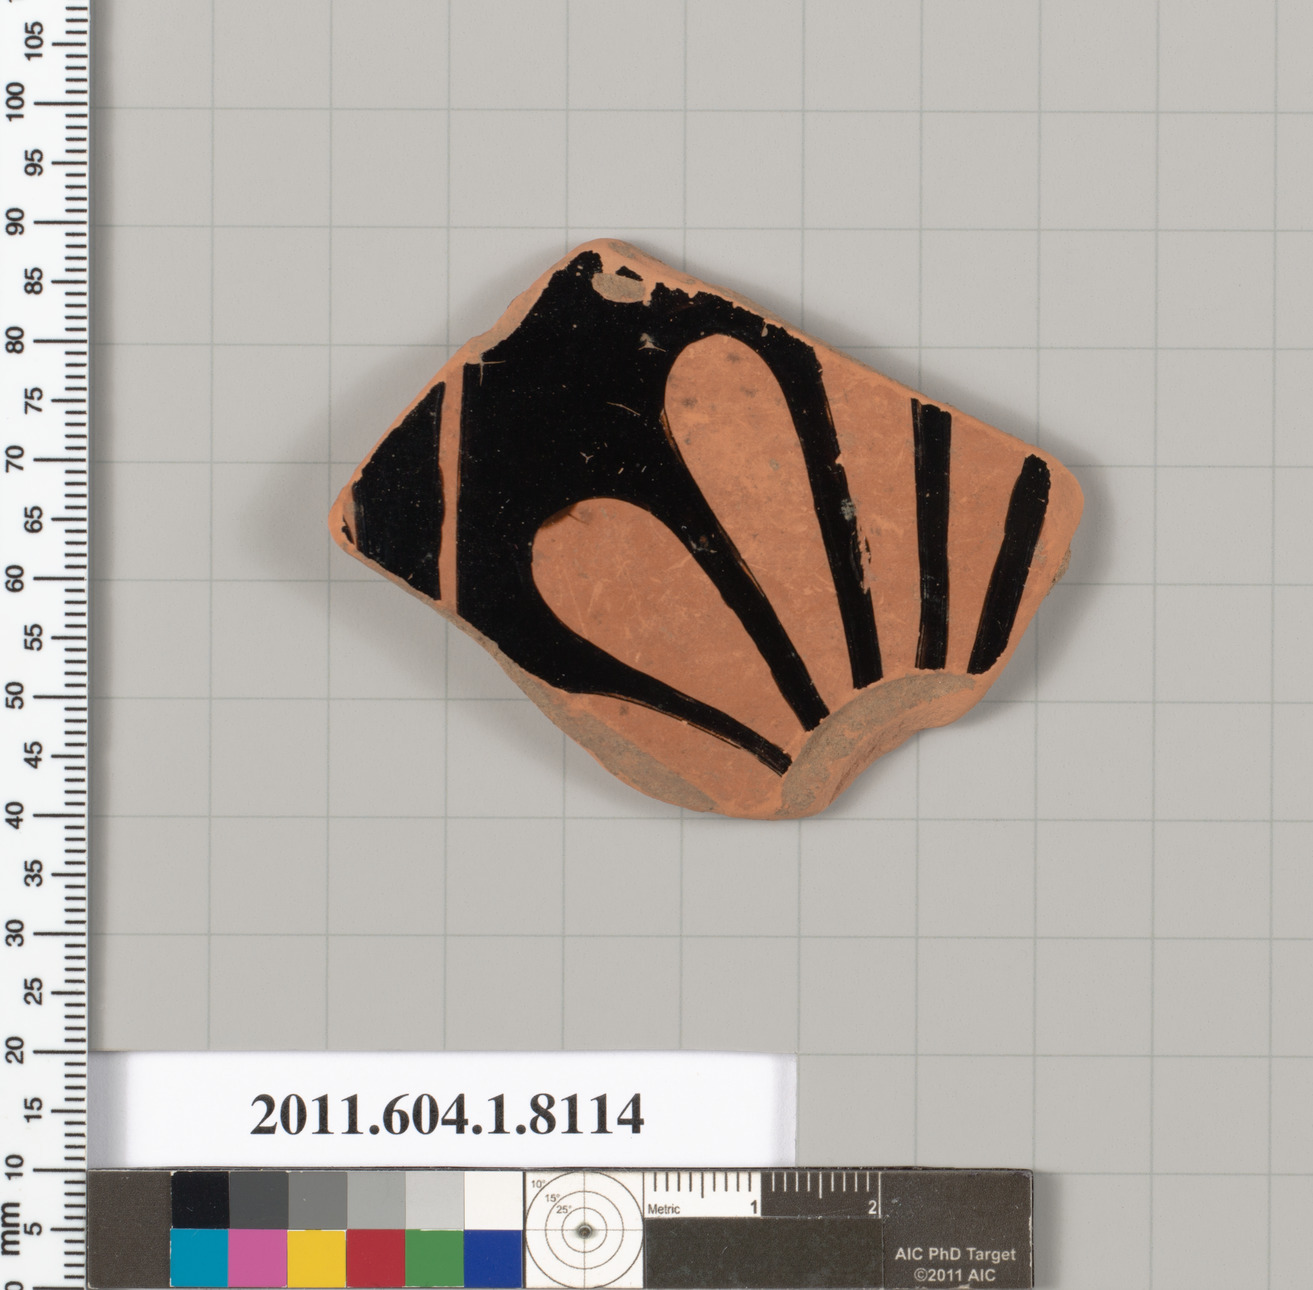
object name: kylix fragment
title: Terracotta fragment of a kylix (drinking cup)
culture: greek, attic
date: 534-468 BCE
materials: terracotta